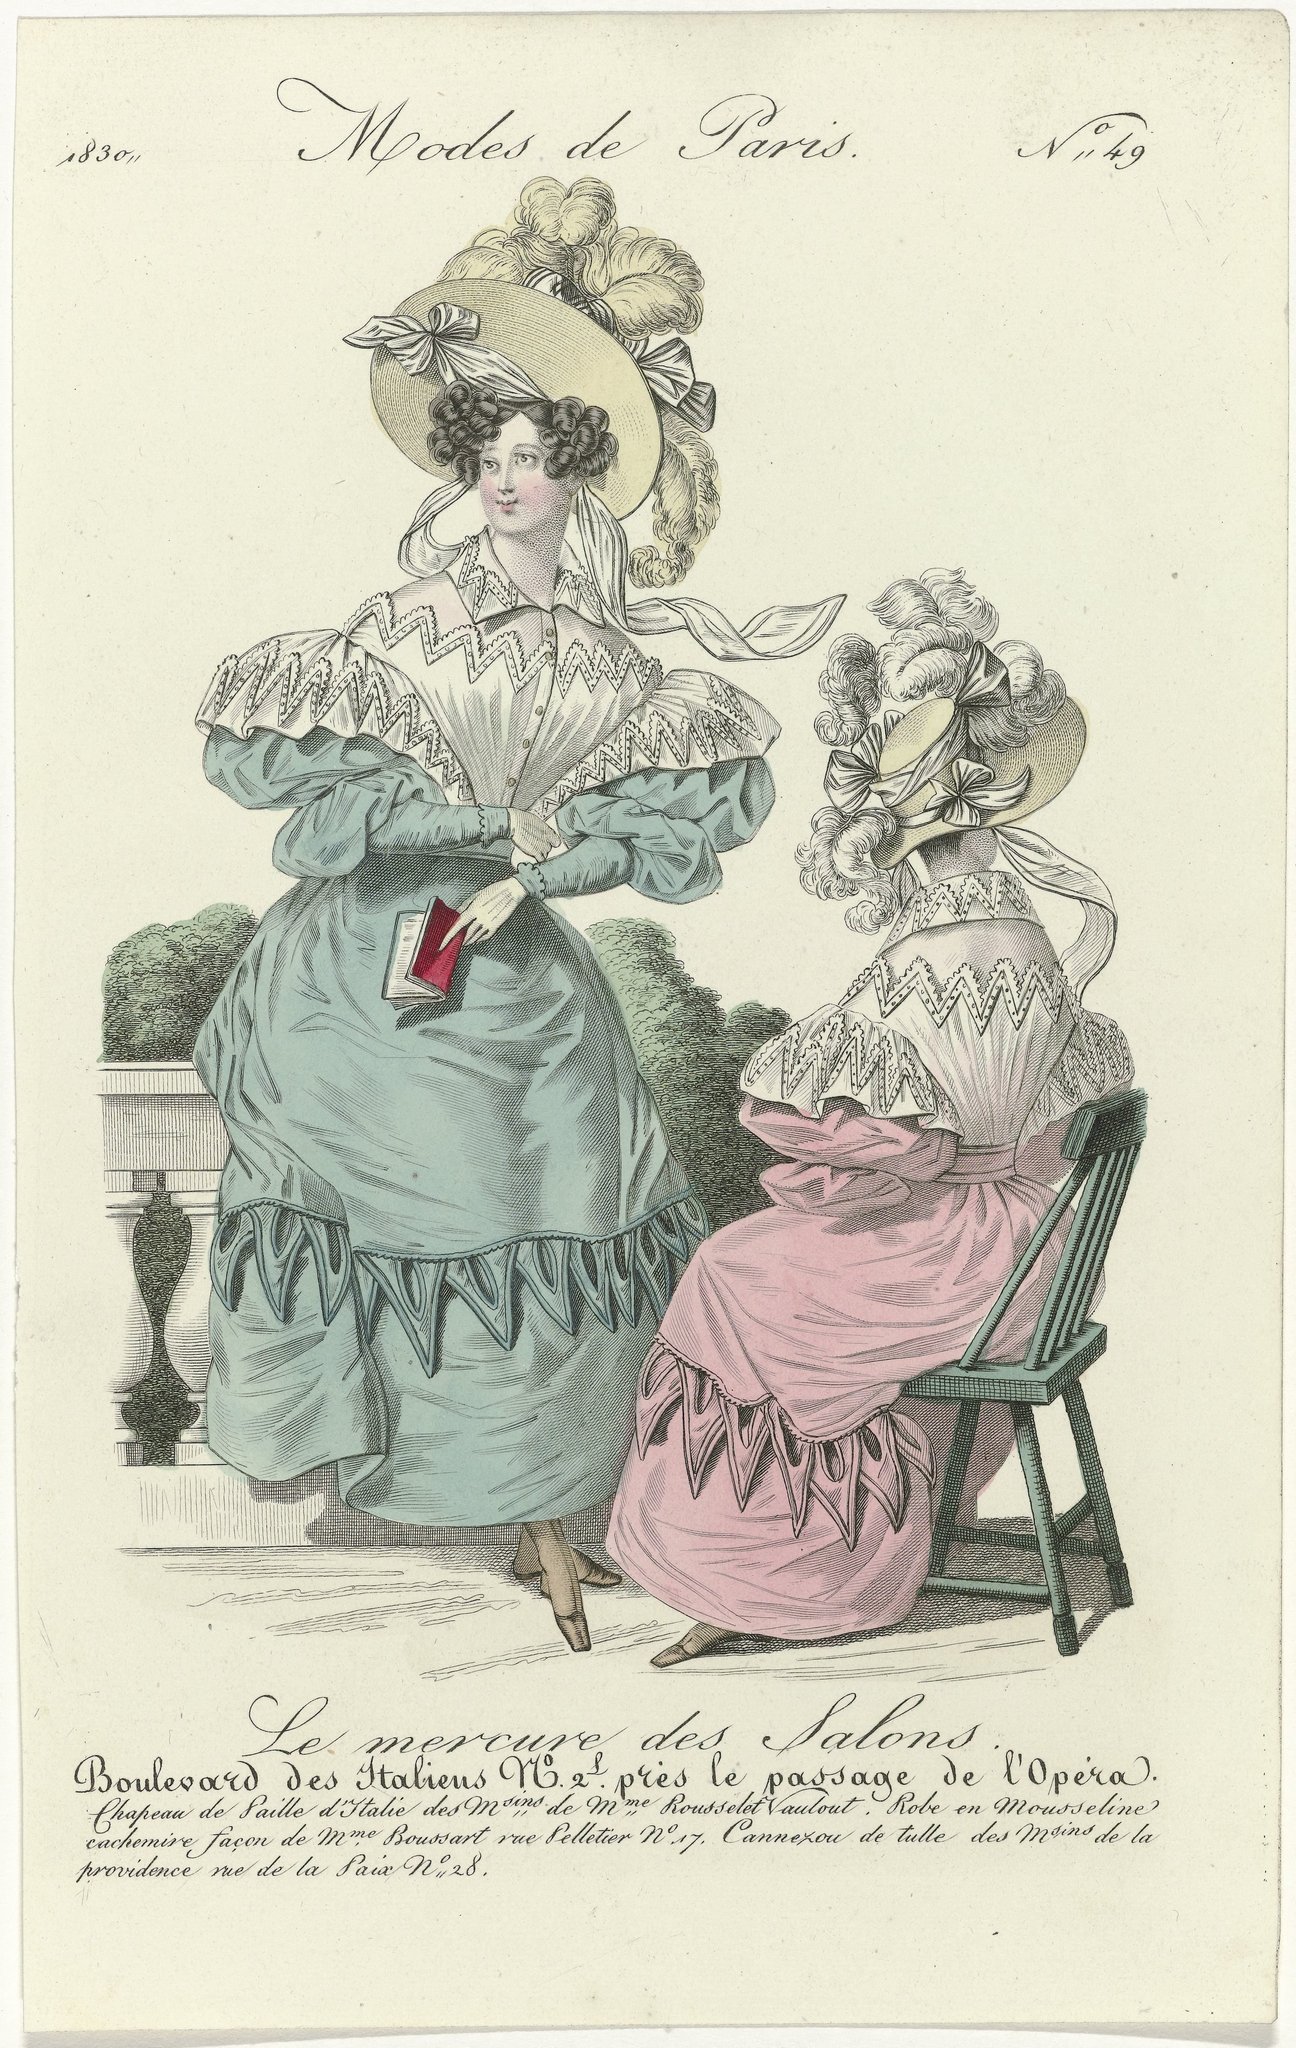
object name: fashion print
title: Le Mercure des Salons, Modes de Paris, 1830, No. 49: Chapeau de paill (...)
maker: Anonymous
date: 1830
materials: paper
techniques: engraving, hand coloring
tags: fashion plates, head-gear: hat (+ women's clothes), gloves, mittens, etc. (+ women's clothes), dress, gown (+ women's clothes), book - mm - book open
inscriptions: address: ‘Boulevard des Italiens No. 2l. près le passage de l'Opéra.’, title: ‘Le mercure des Salons.’, title: ‘Modes de Paris.’, caption: ‘Chapeau de Paille d'Italie des M"sins de M"me Rousselet Vaulout. Robe en Mousseline cachemire façon de M.me Boussart rue Pelletier No. 17. Cannezou de tulle des Msins de la providence rue de la Paix No" 28.’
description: Hoed van 'paille d'Italie' uit de winkels van Rousselet Vaulout. Japon van 'mousseline cachemire' uitgevoerd op de manier van Mme Boussart. 'Canezou' van tule uit de winkels van 'la providence'. Verdere accessoires: handschoenen, laarzen met vierkante neuzen. Prent uit het modetijdschrift Le Mercure des Salons (janvier 1830 - mars 1831)